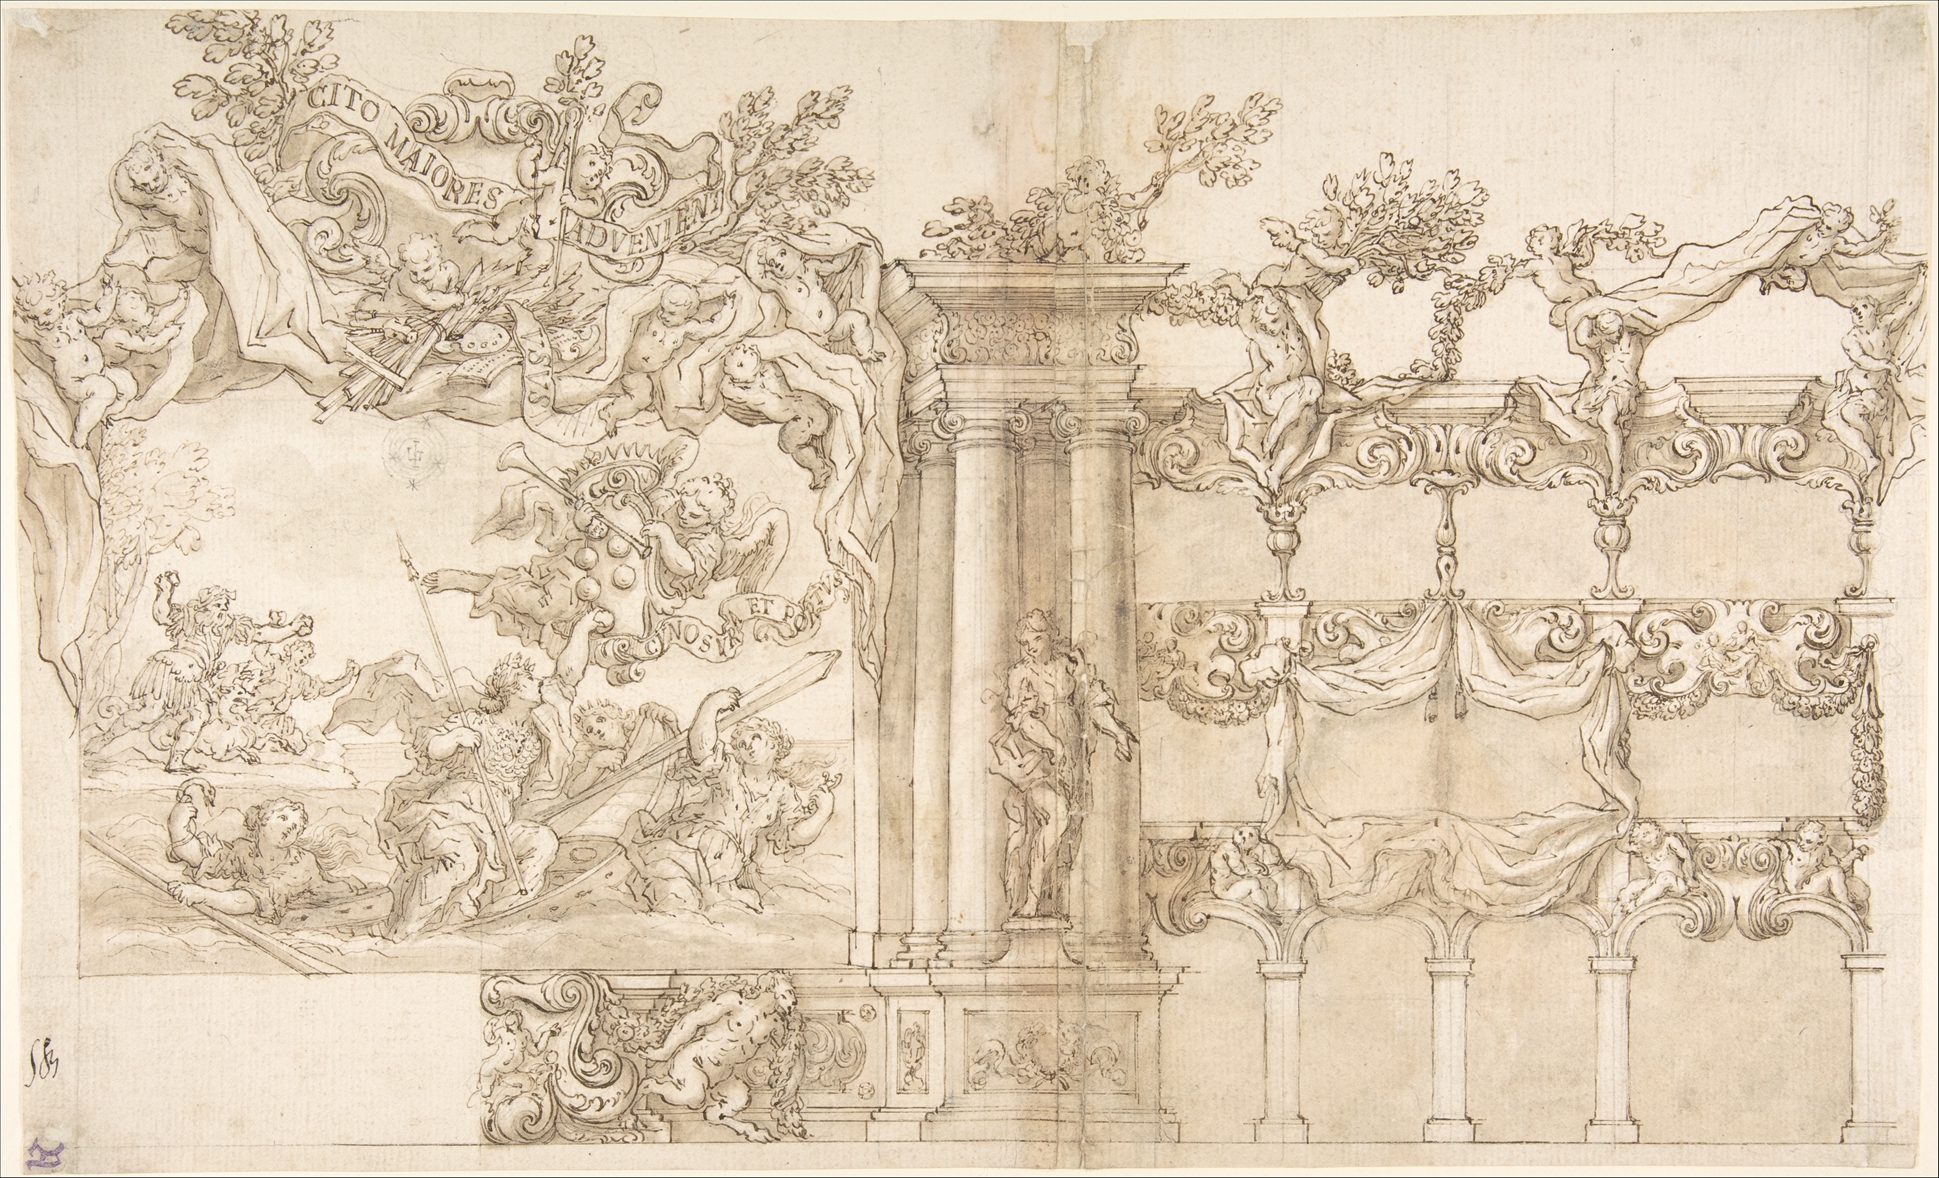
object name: drawing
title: Design for a Theatre, or Hall for a Special Fête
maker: giacomo chiavistelli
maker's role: artist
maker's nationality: italian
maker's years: 1621-1698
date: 1688-1690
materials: chalk, ink, drawing material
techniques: brush, pen, wash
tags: theatre,architecture